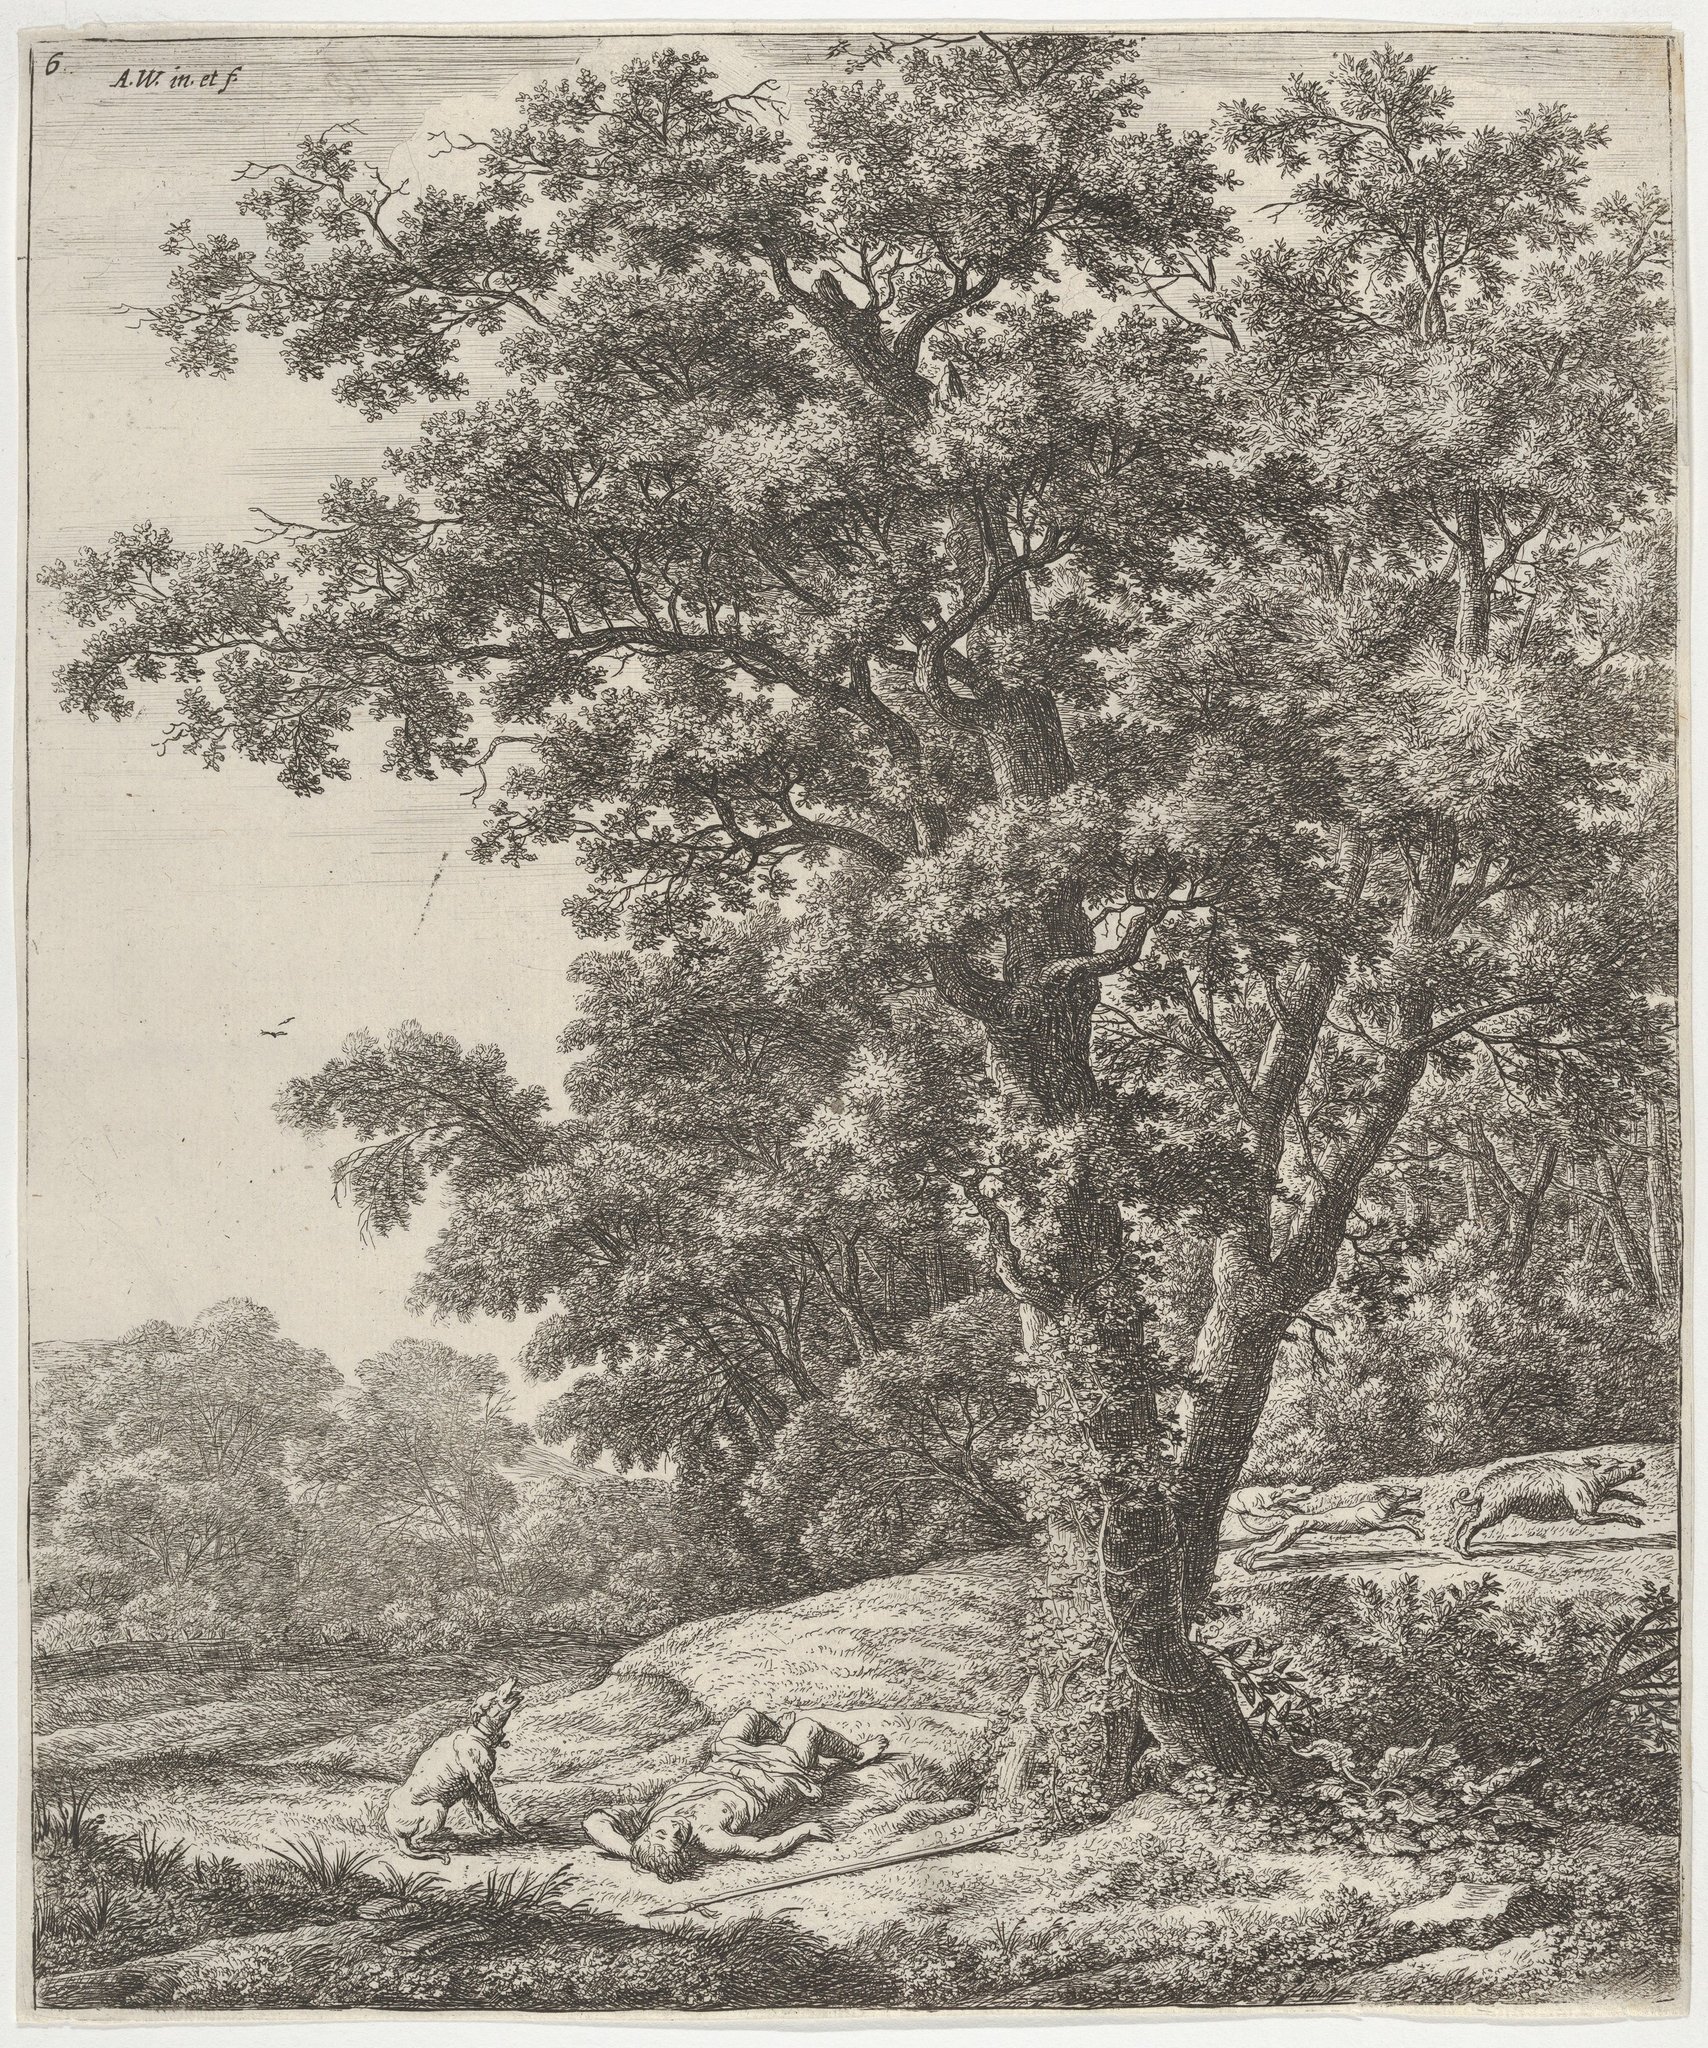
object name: print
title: Landscape with the Death of Adonis, from the Series of Six Mythological Scenes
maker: anthonie waterloo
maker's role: artist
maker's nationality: dutch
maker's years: 1609-1690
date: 1610-1690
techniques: etching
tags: animals,adonis,landscapes,death